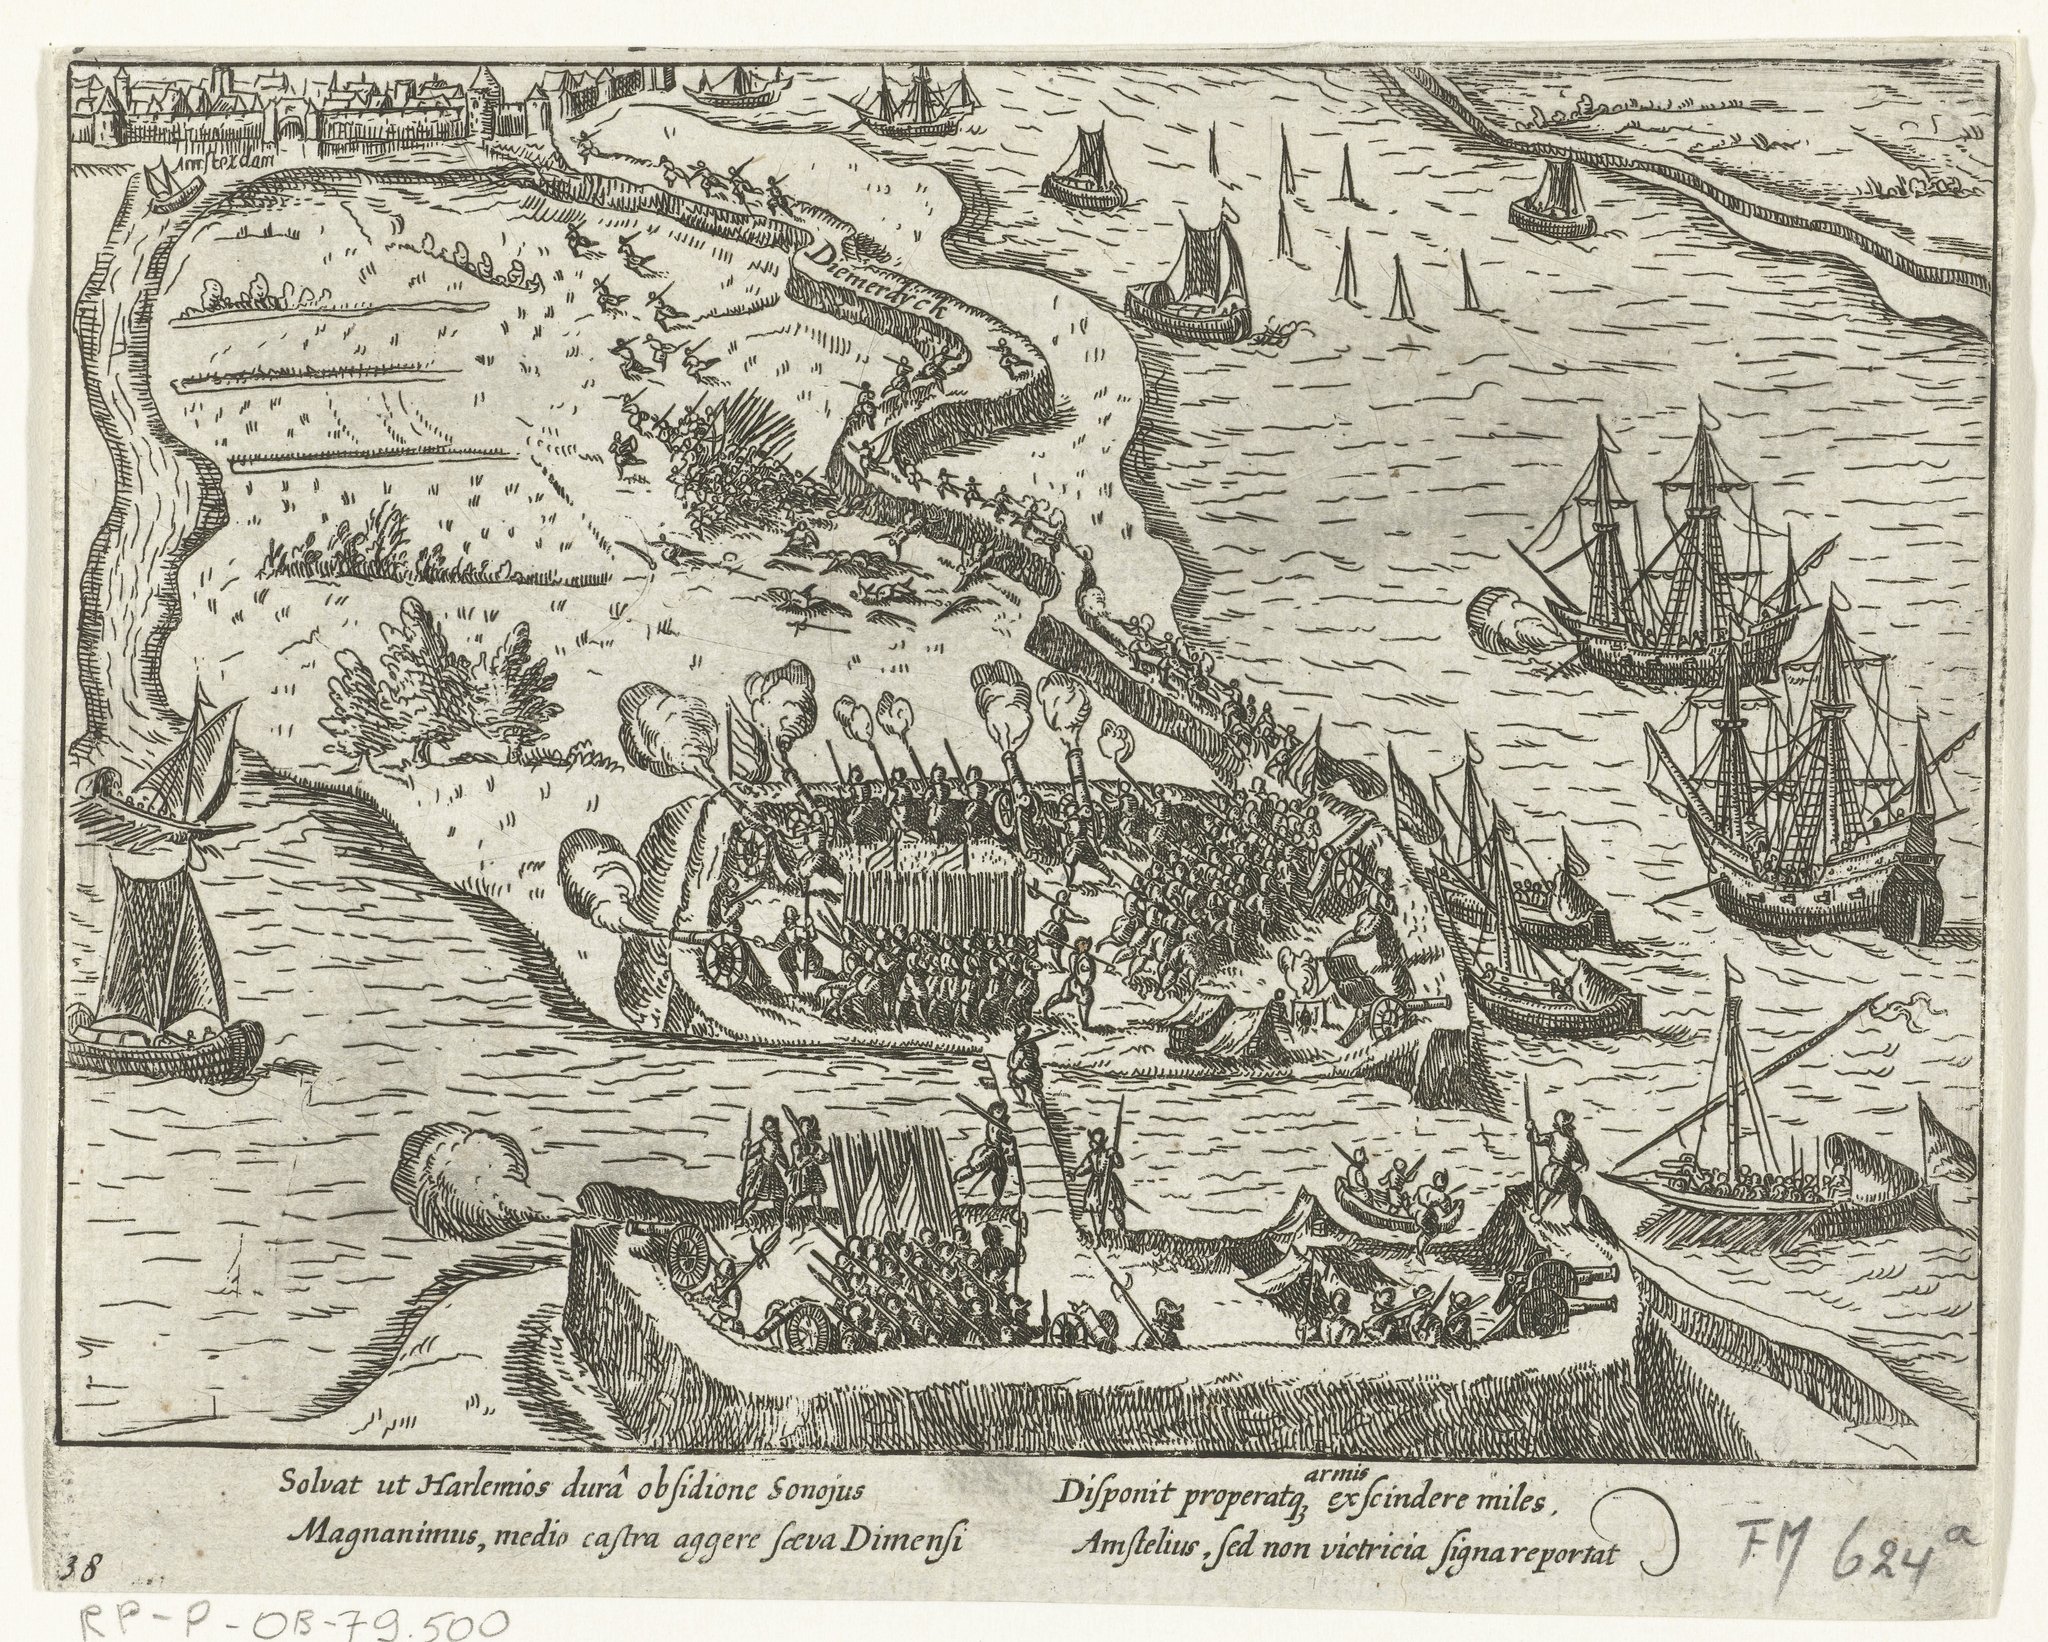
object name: print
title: Slag op de Diemerdijk, 1573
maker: Anonymous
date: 1613-1615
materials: paper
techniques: etching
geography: northern netherlands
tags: battle (+ land forces), amsterdam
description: Slag op de Diemerdijk bij Amsterdam, juni 1573. De Diemerdijk door soldaten onder Sonoy op 2 juni veroverd, doorgegraven, versterkt en bezet gehouden tot 17 juli. Met onderschrift van 4 regels in het Latijn. Genummerd: 38. Bedrukt op achterzijde met tekst in het Latijn.